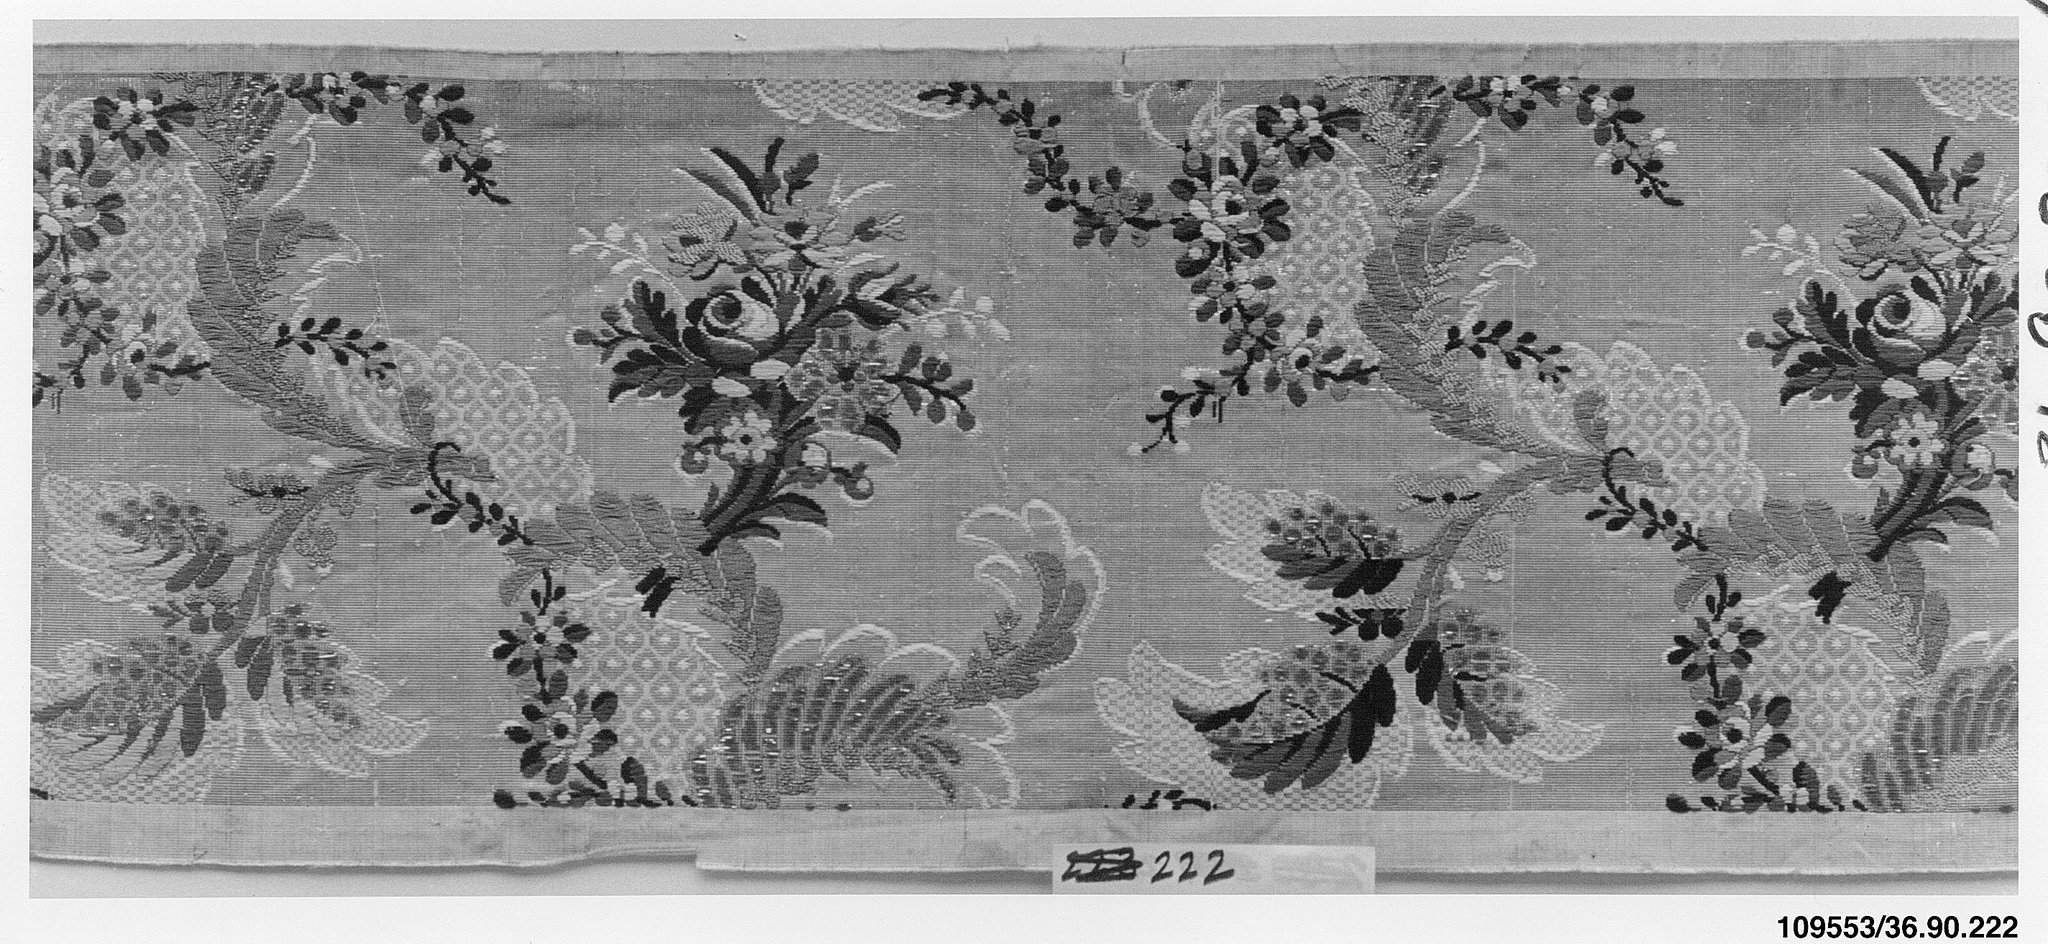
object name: piece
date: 1750-1760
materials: metal thread, silk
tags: flowers,leaves